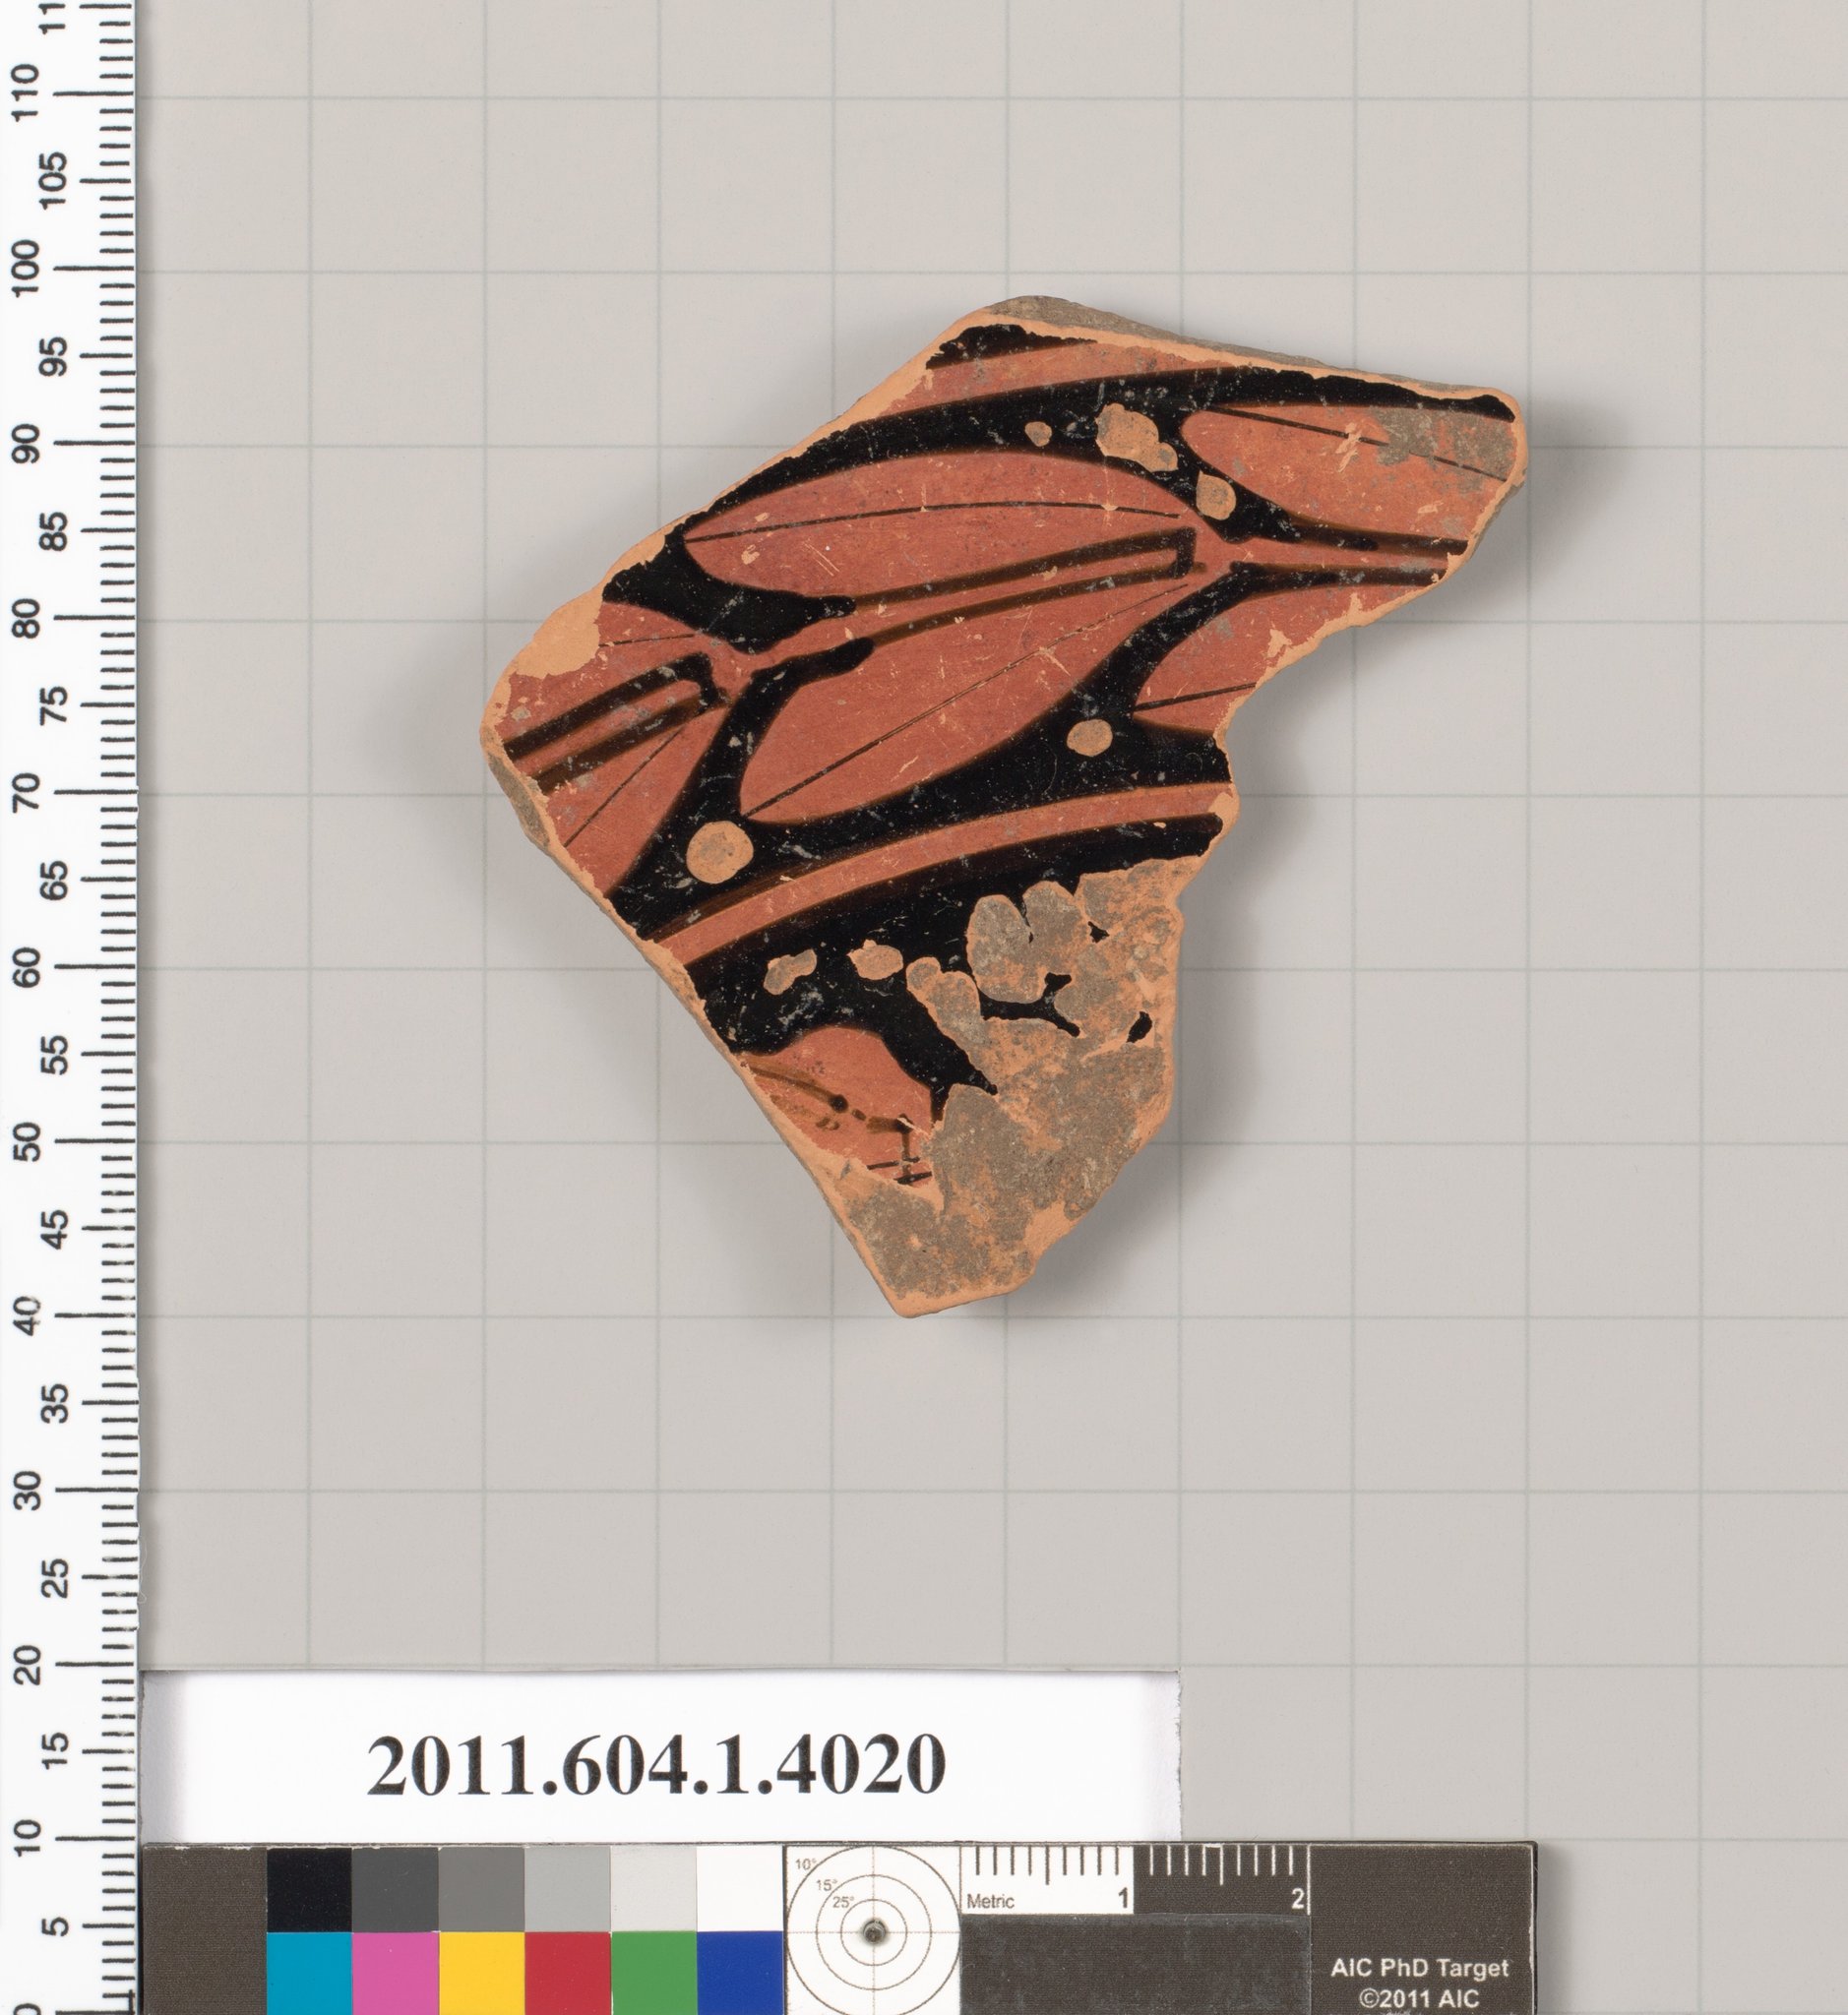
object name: kylix fragment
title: Terracotta fragment of a kylix (drinking cup)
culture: greek, attic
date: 460-440 BCE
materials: terracotta